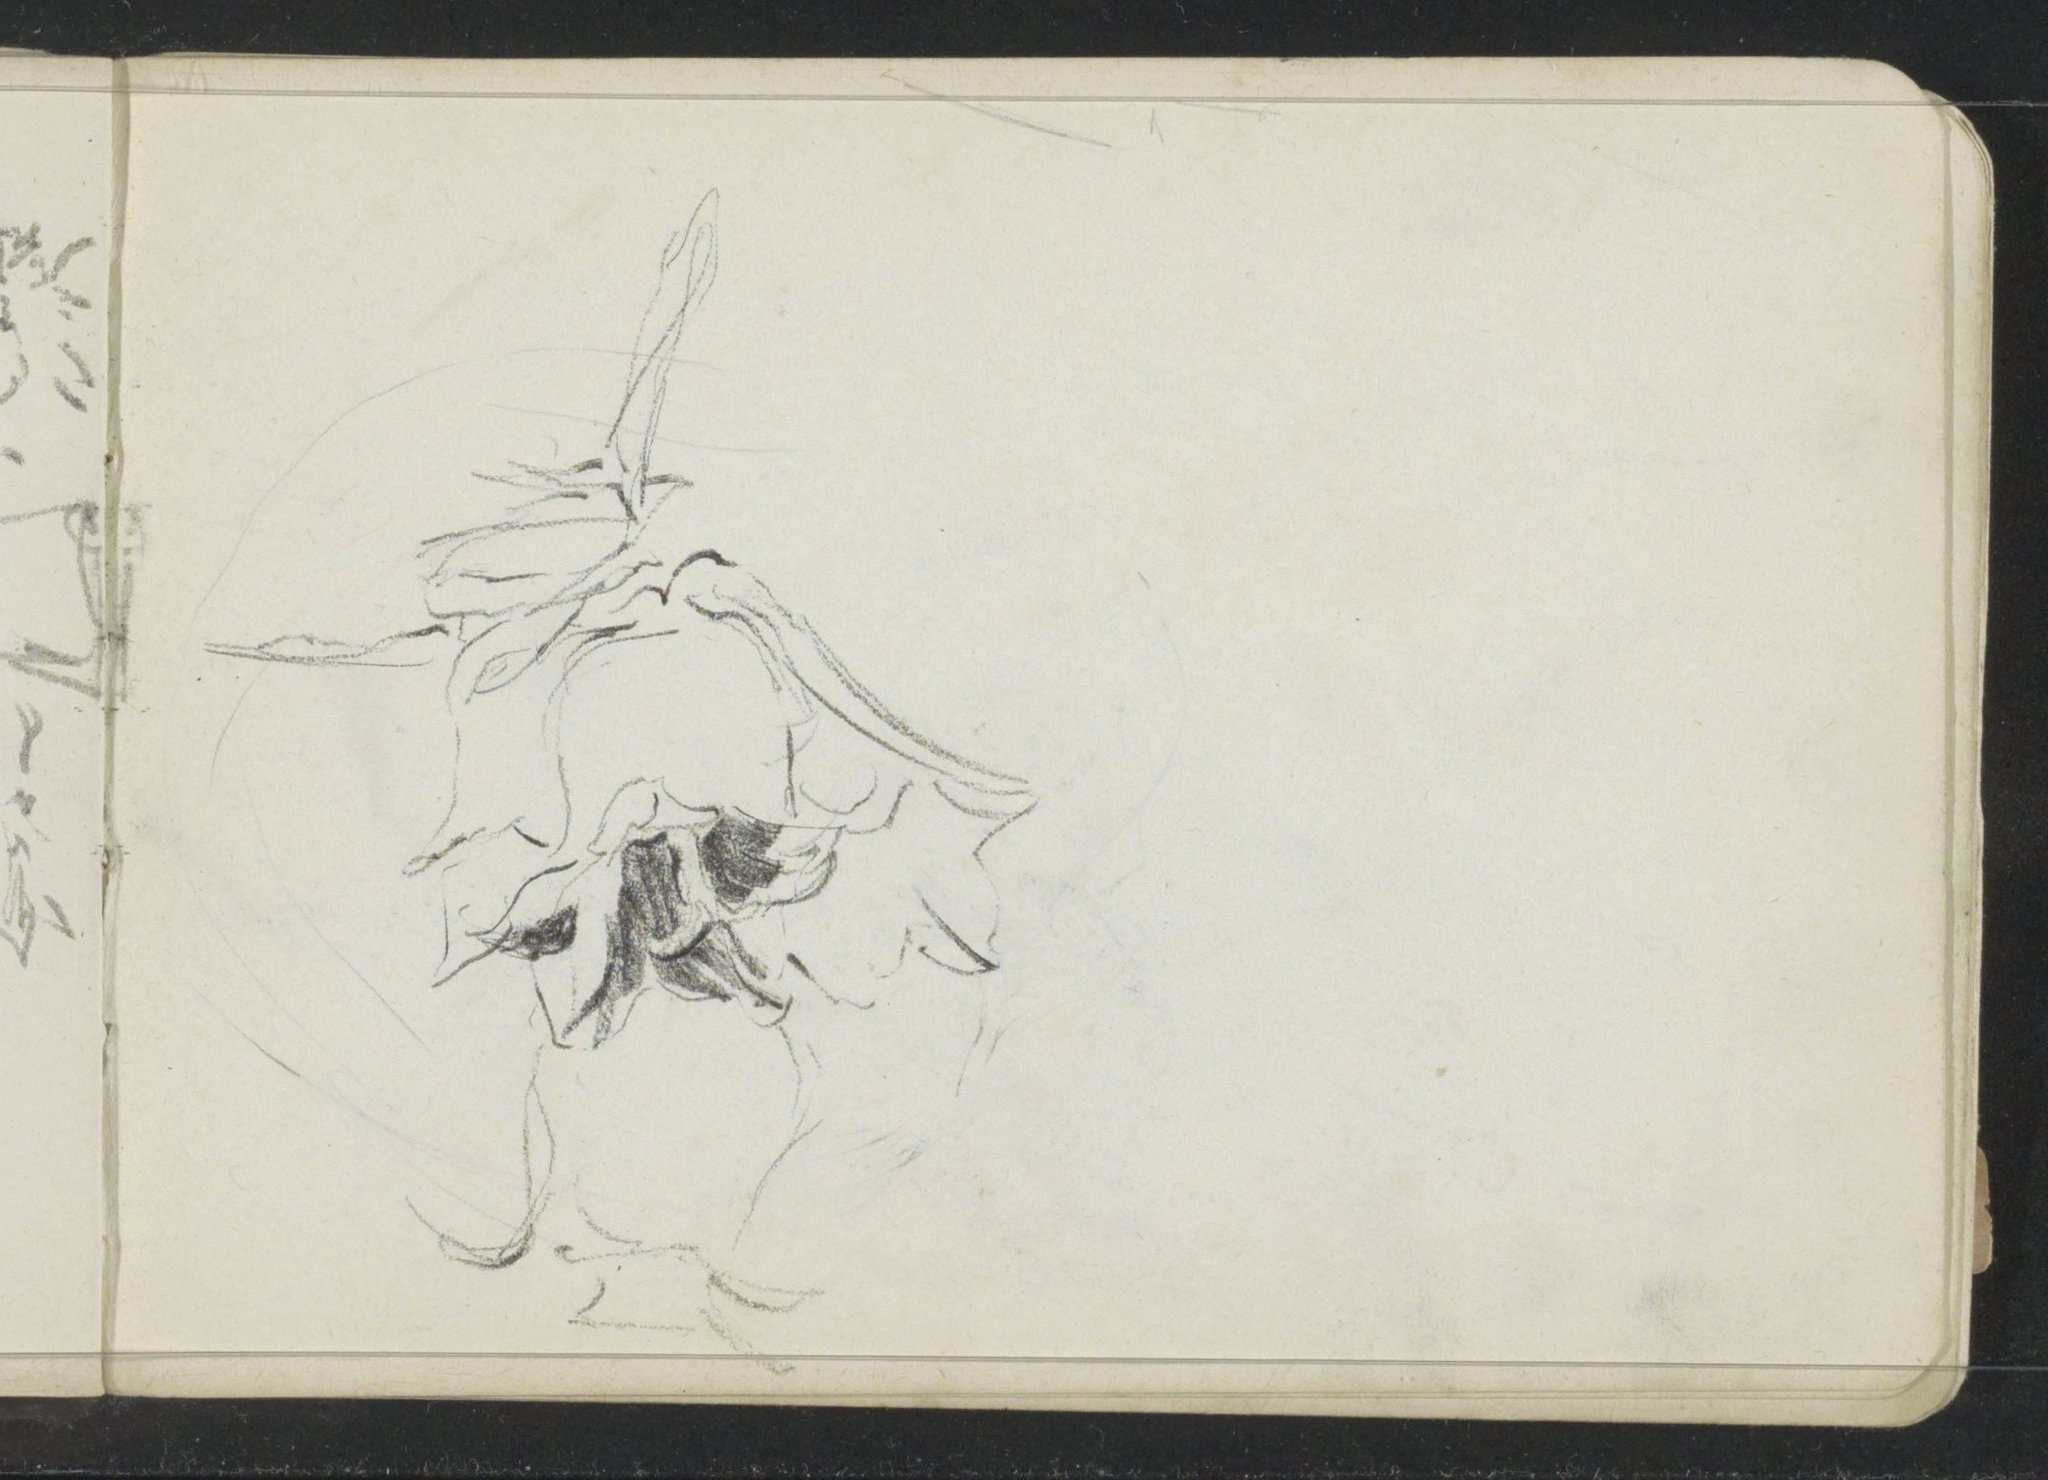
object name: sketchbook leaf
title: Roos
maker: johanna van de kamer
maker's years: 1873-1922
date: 1883-1922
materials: chalk, paper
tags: flowers: rose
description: Blad 16 recto uit een schetsboek met 27 bladen.